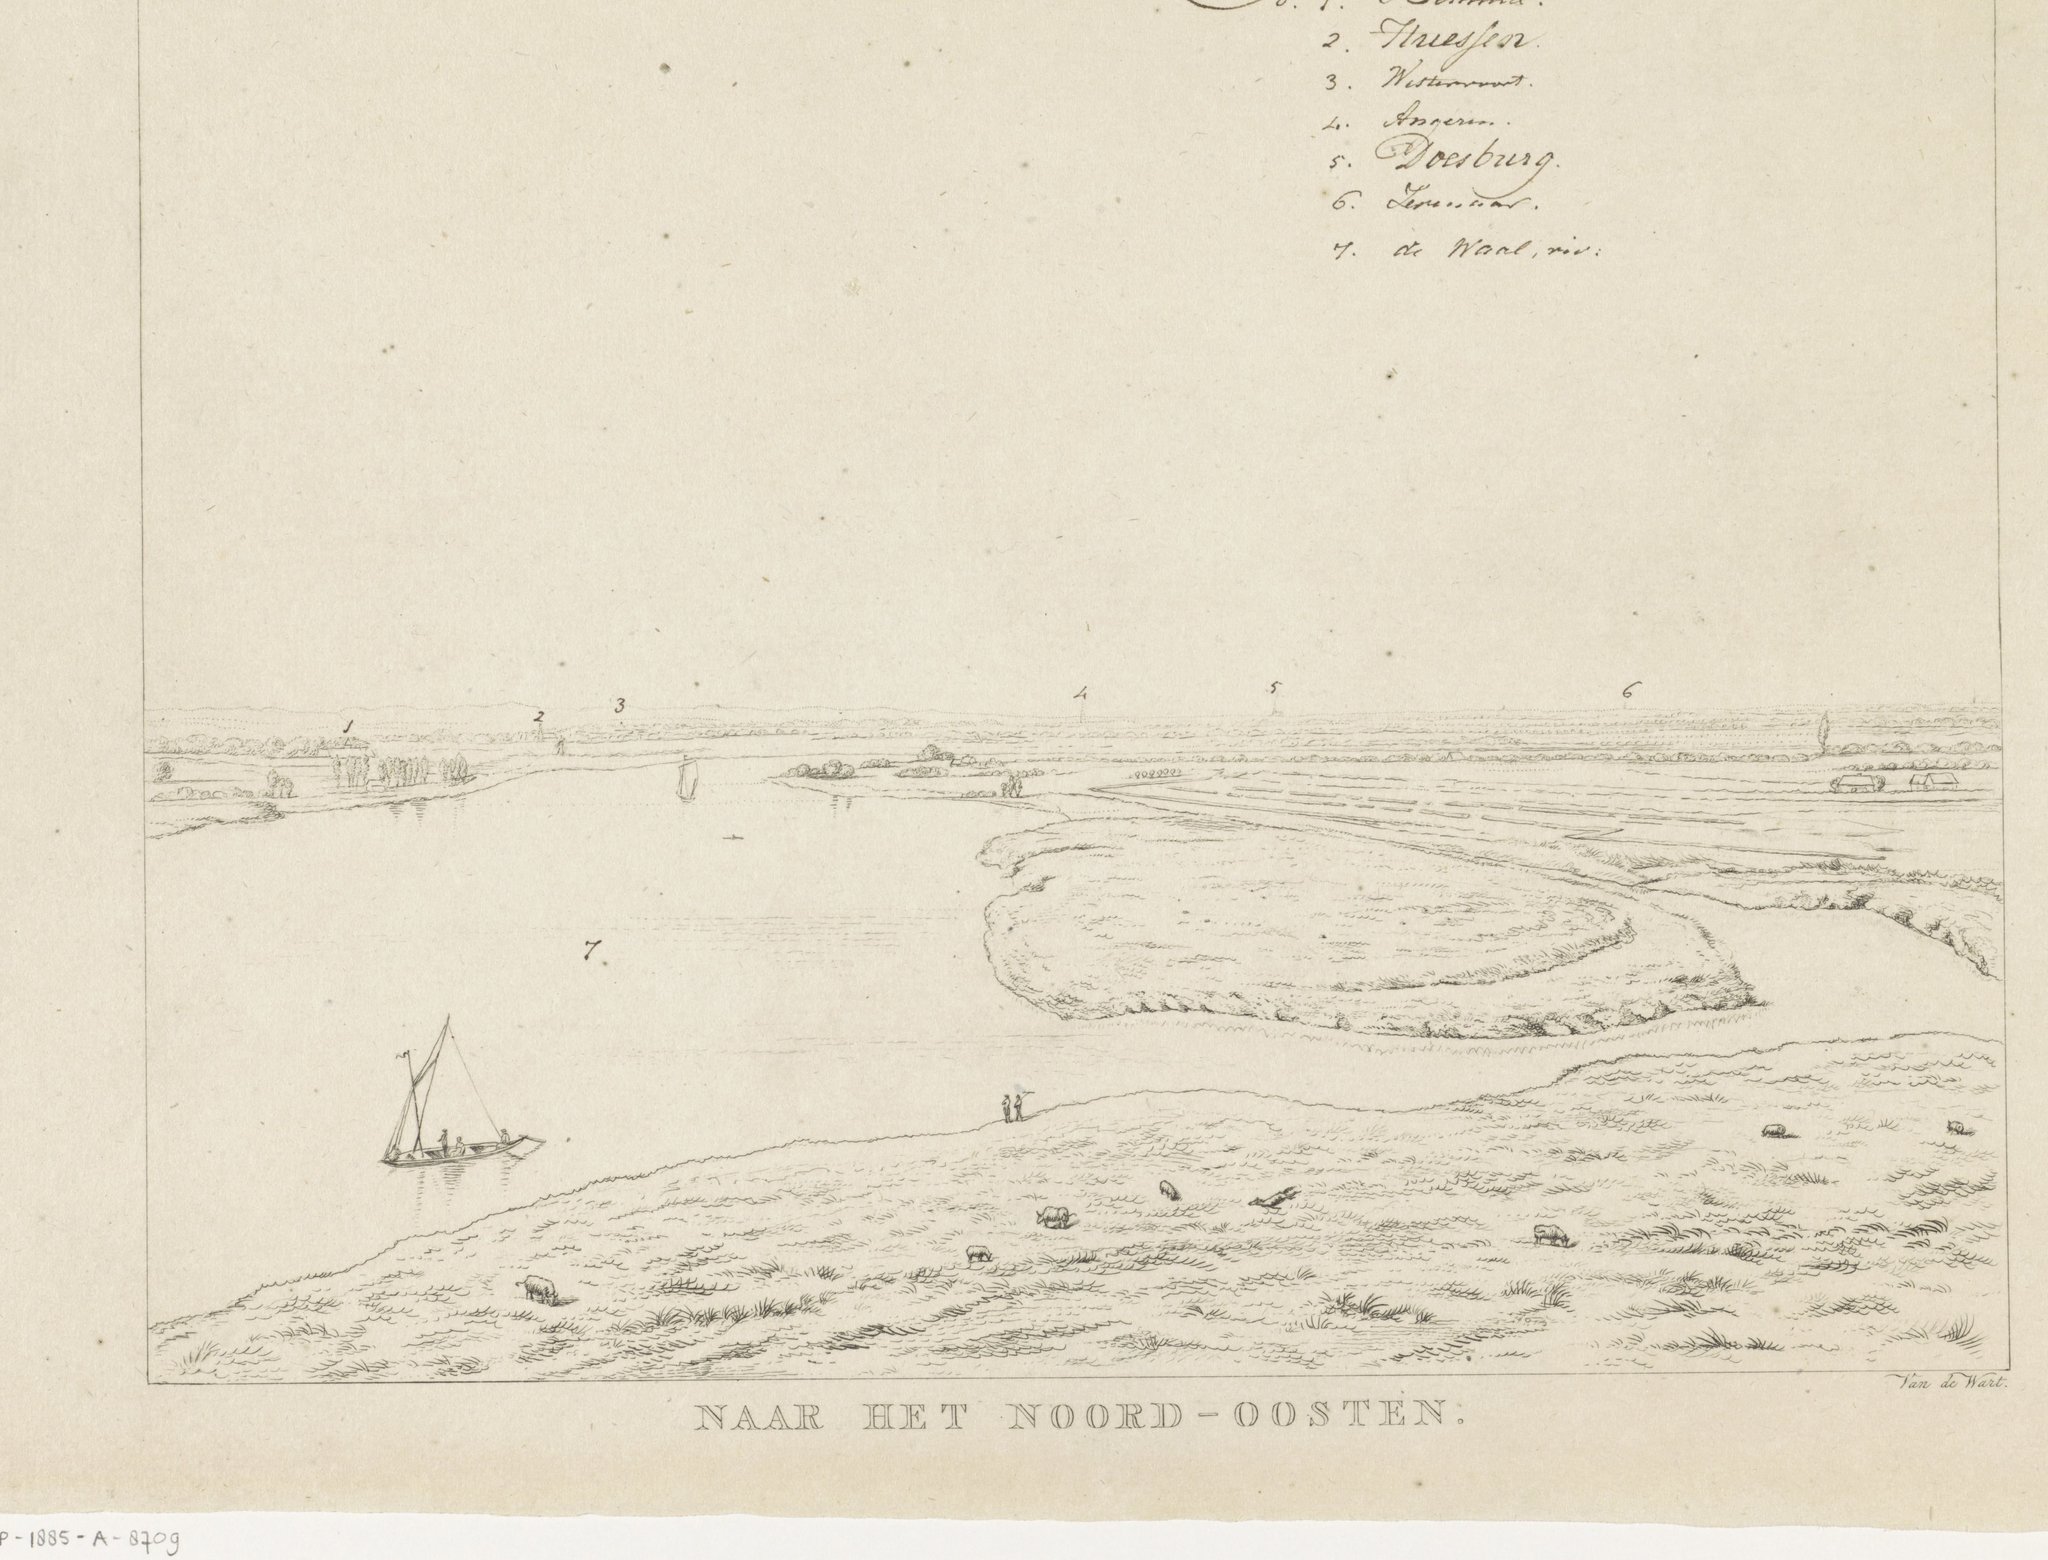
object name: print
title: Geldersch panorama of rondgezicht naar het leven geteekend op belvedére te Nymegen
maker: derk anthony van de wart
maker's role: draughtsman, painter, print maker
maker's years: 1767-1824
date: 1815-1824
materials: ink, paper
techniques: etching, pen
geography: nijmegen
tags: river, nijmegen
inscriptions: collector's mark: Lugt 2228, inscription: ‘No. 1. Bemmel. 2. Huessen. 3. Westervoort. 4. Angeren. 5. Doesburg. 6. Zevenaar. 7. de Waal, riv:’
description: Gezicht op de Waal. Op de rivier is een boot te zijn en op de oever graast een kudde schapen. Aan de horizon zijn de kerktorens van de steden Bemmel, Huissen, Westervoort, Angeren, Doesburg en Zevenaar weergegeven. De prent is een onderdeel van een suite van negen prenten, inclusief de titelprent.